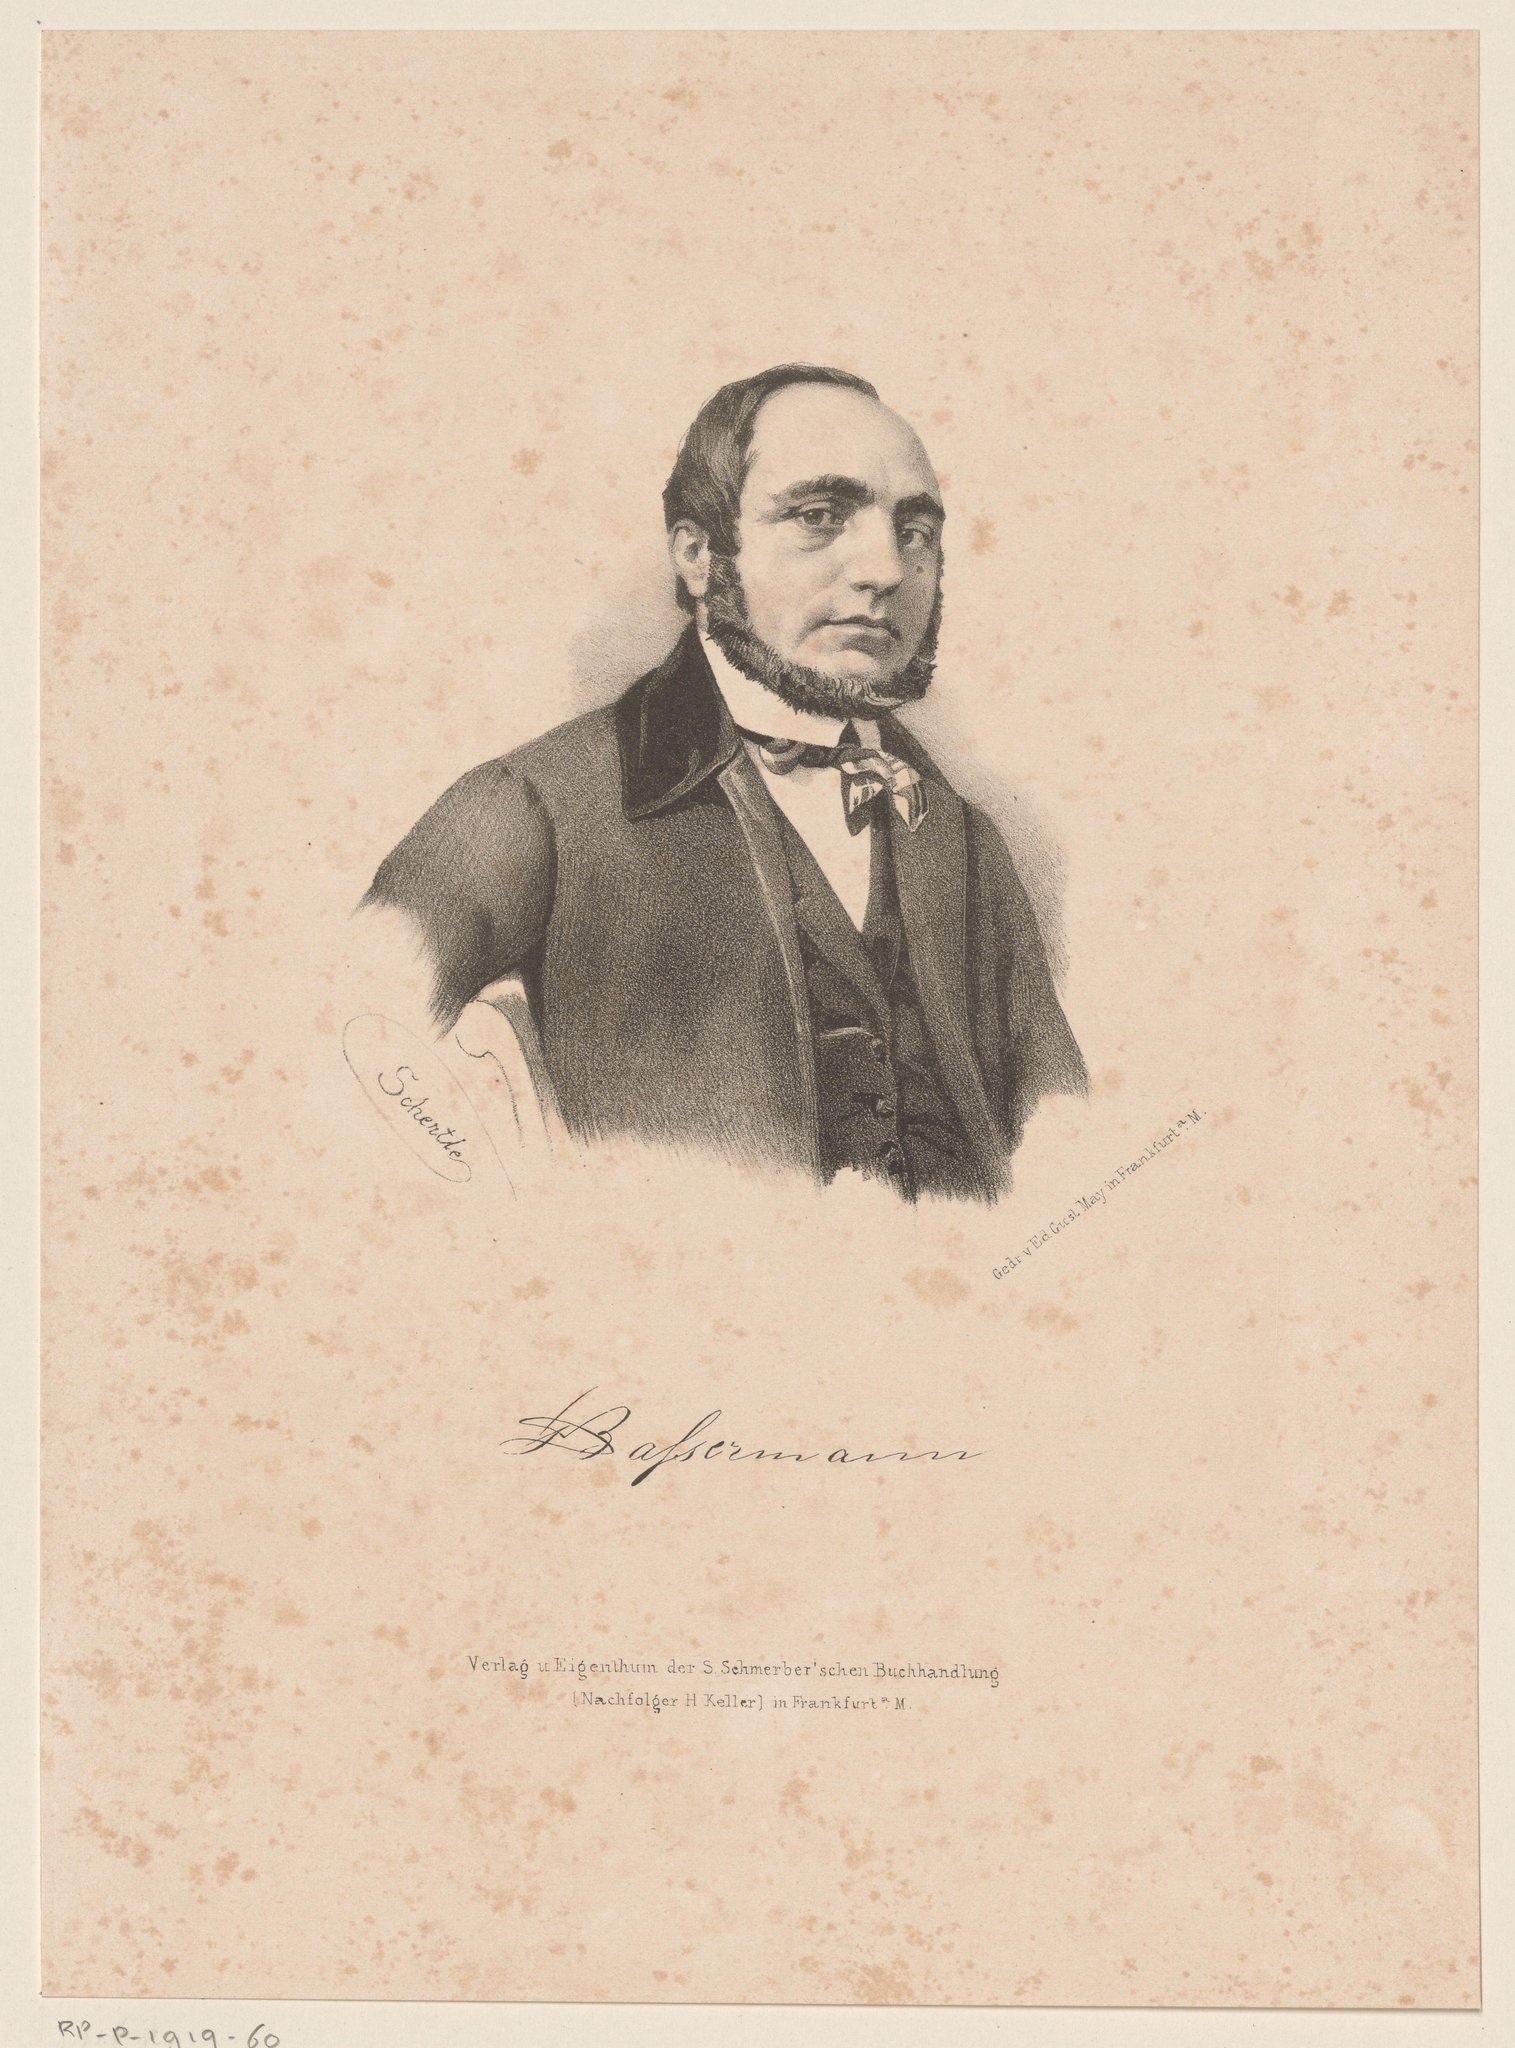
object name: print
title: Portret van Friedrich Daniel Bassermann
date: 1845-1878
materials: paper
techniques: lithograph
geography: frankfurt am main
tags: politician, historical persons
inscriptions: collector's mark: Lugt 2228